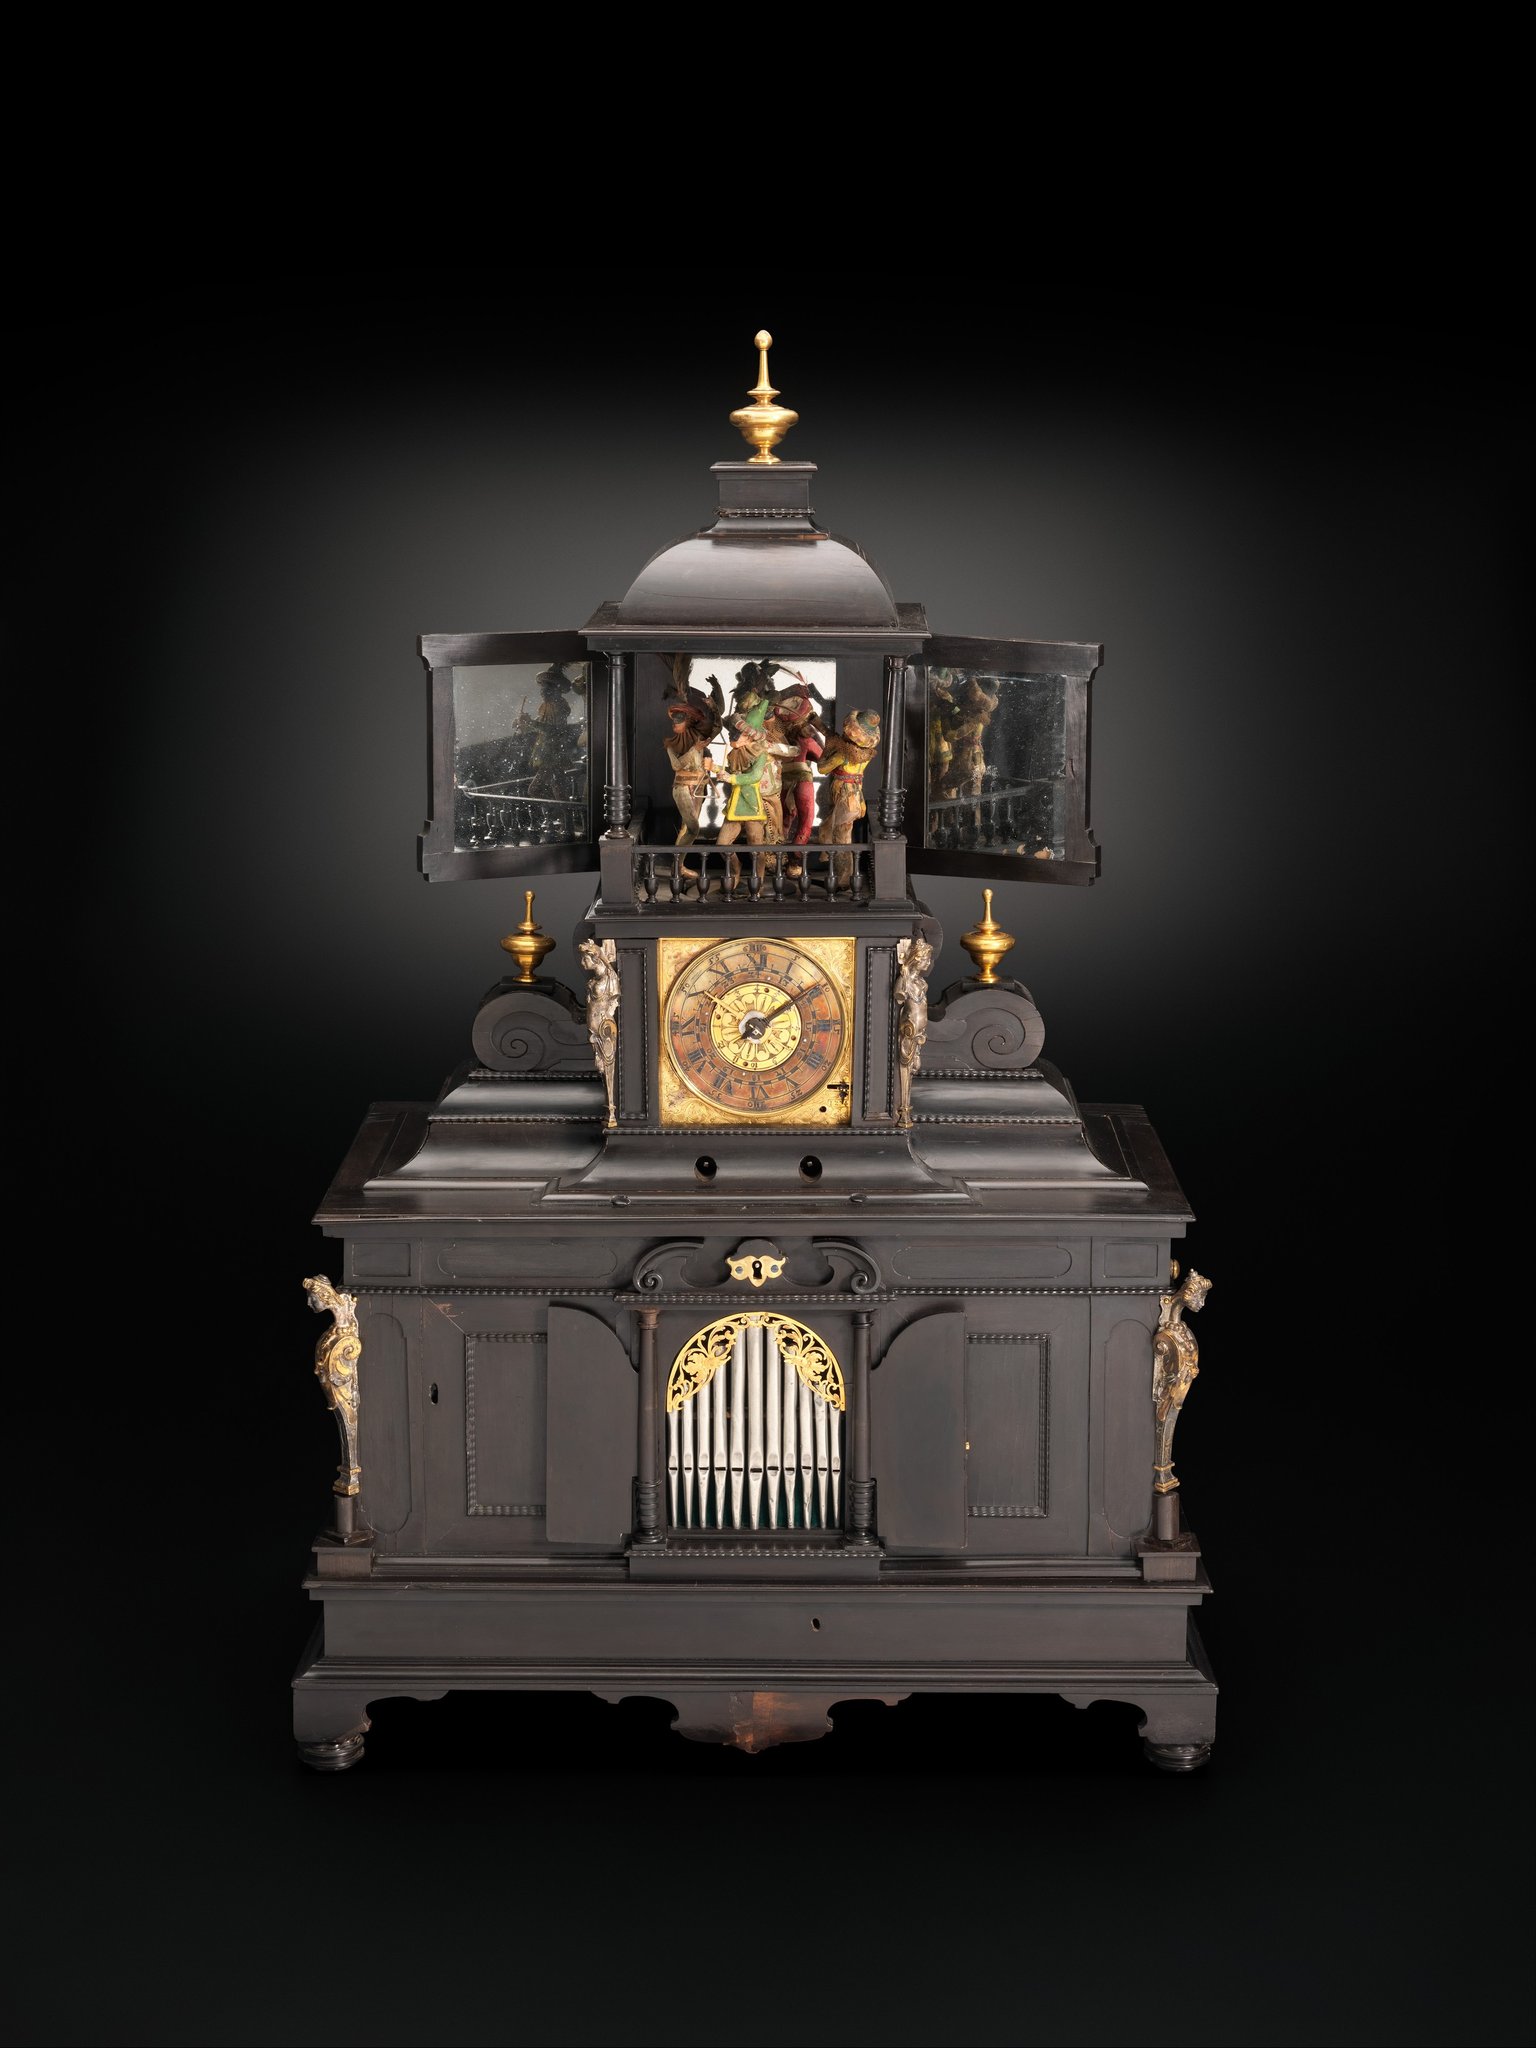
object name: musical clock with spinet and organ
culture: german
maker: veit langenbucher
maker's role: maker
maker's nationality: german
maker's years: 1587-1631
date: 1625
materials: brass, wood, gilt, iron, leather, metal, parchment, silver gilt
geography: germany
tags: musicians